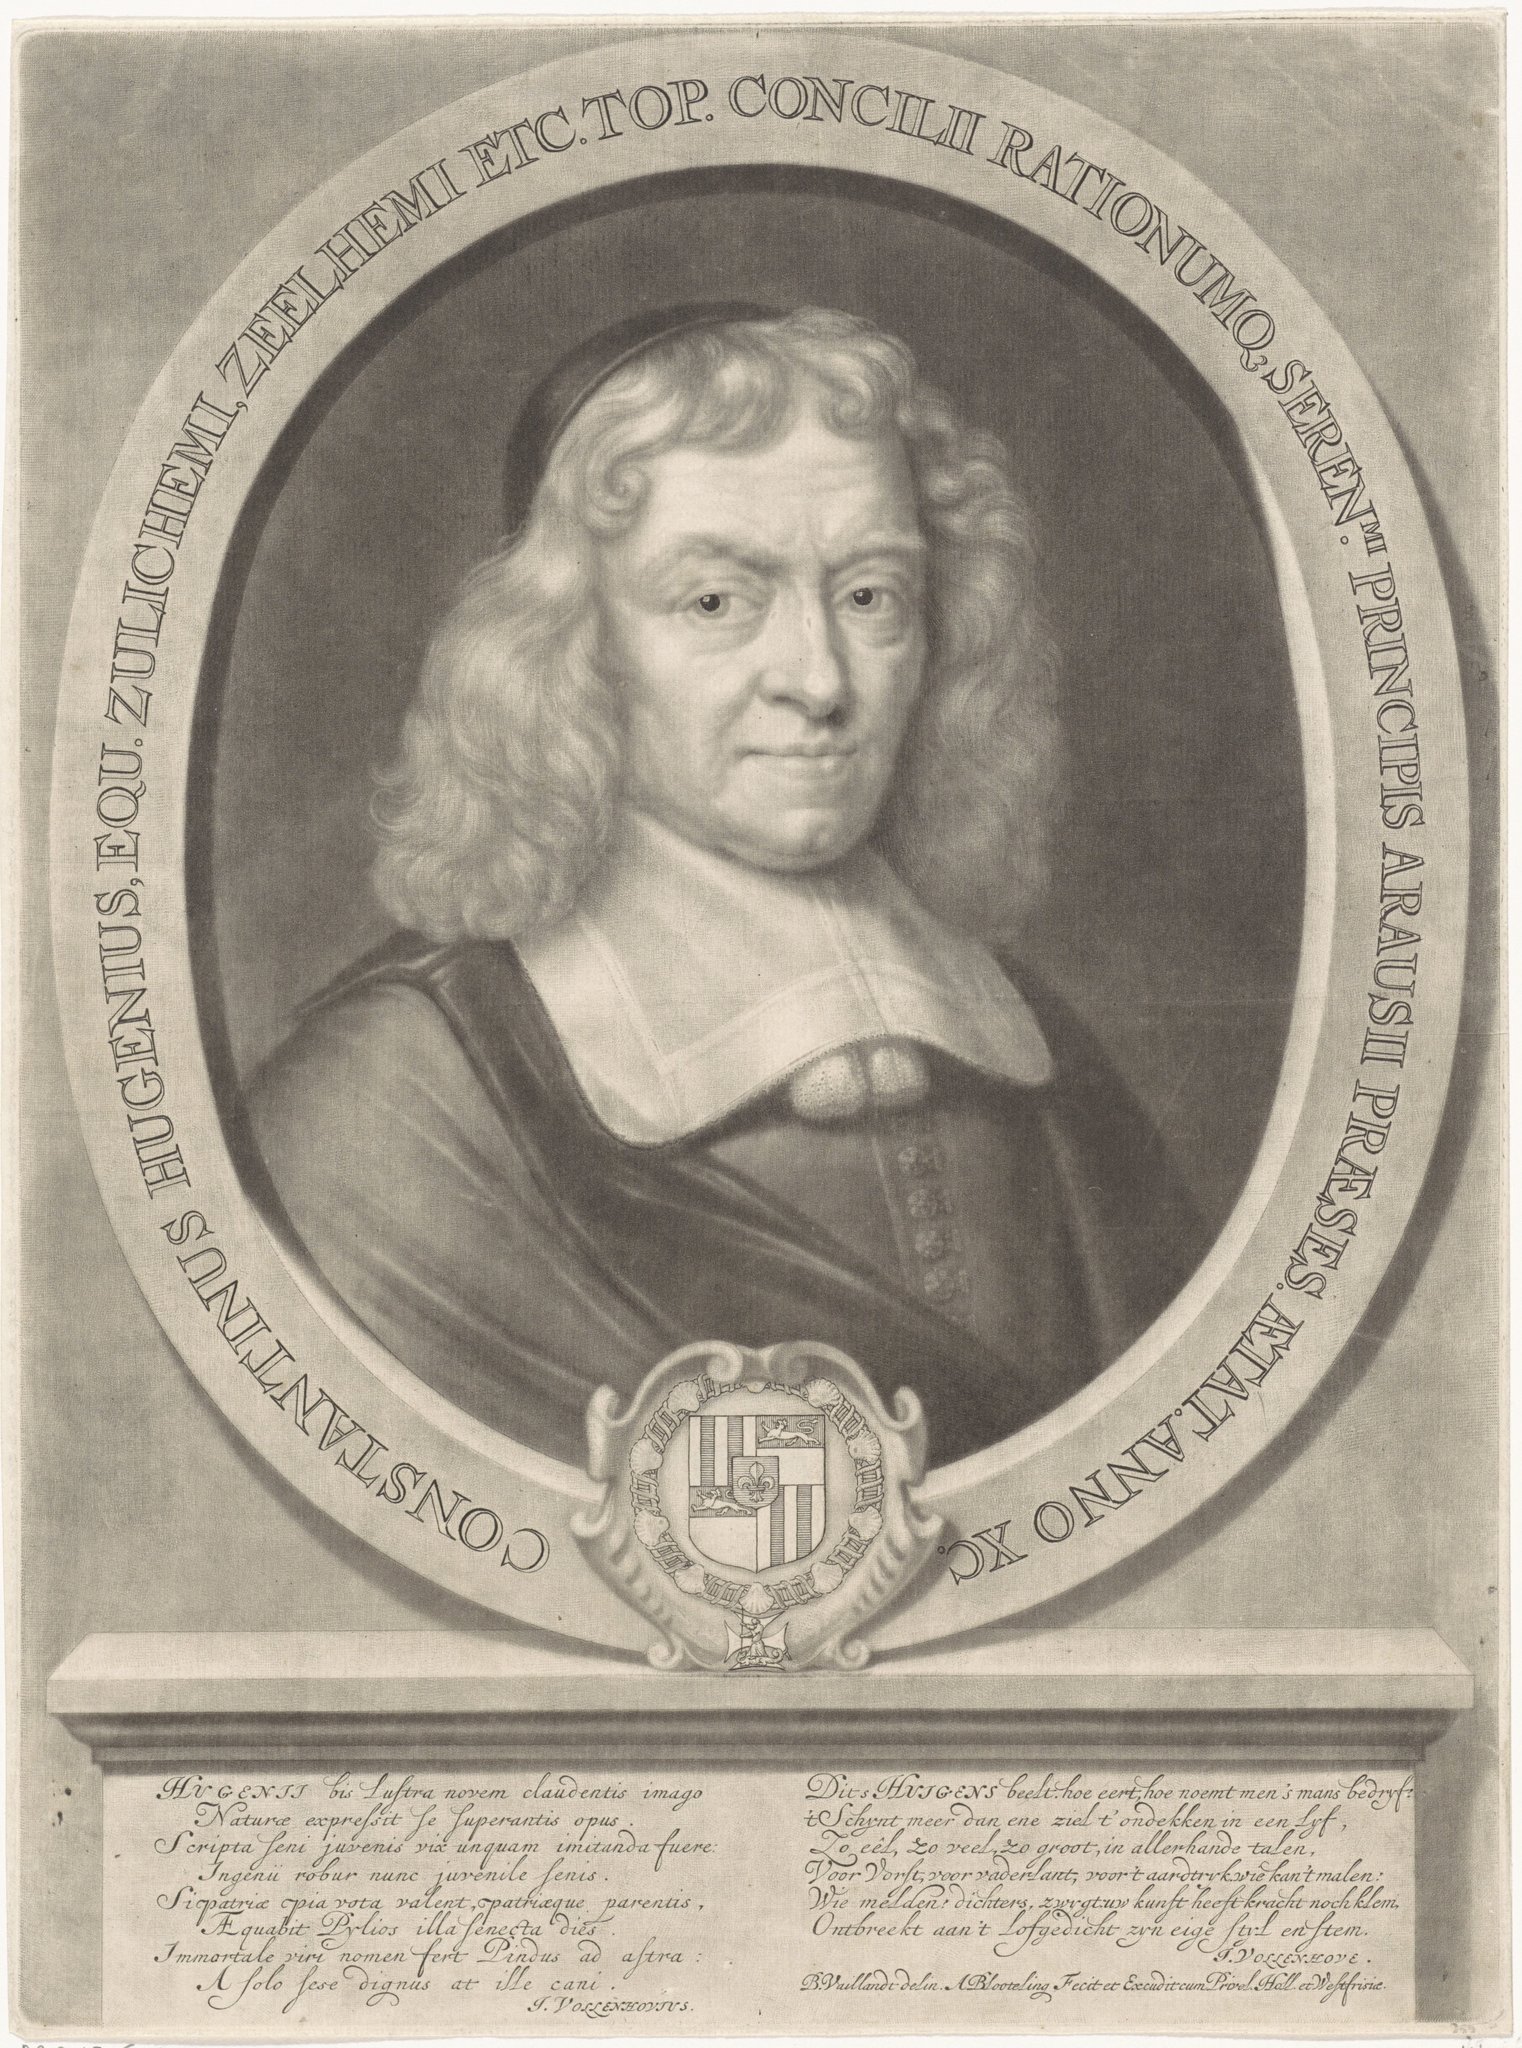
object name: print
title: Portret van Constantijn Huygens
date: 1690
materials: paper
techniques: engraving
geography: amsterdam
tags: constantijn huygens (i)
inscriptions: collector's mark: Lugt 2228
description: Portret van Constantijn Huygens, dichter, secretaris van prins Frederik Hendrik en prins Willem II en eerste raad en rekenmeester van prins Willem III. Onder het portret zijn familiewapen.